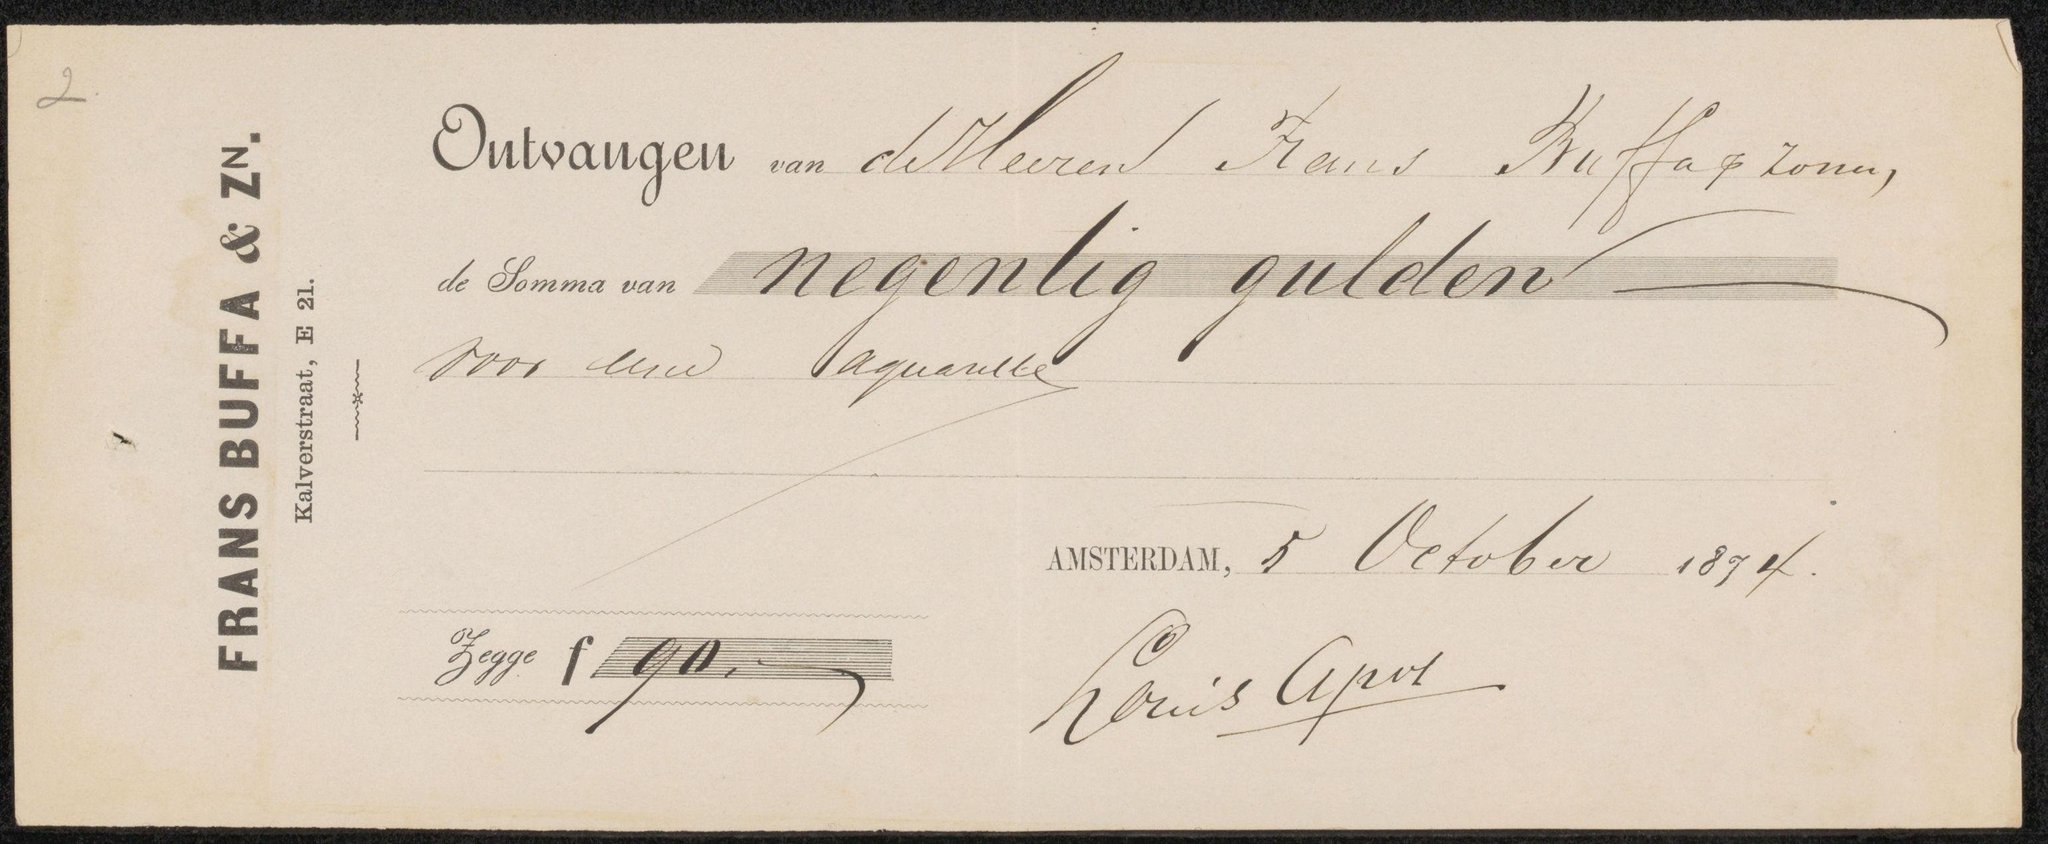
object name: ontvangstbewijs, kwitantie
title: Kwitantie aan Louis Apol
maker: louis apol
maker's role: draughtsman, painter, print maker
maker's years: 1850-1936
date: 1874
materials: ink, paper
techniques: pen, printing, writing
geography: amsterdam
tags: drawing, money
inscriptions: collector's mark: Lugt 2233